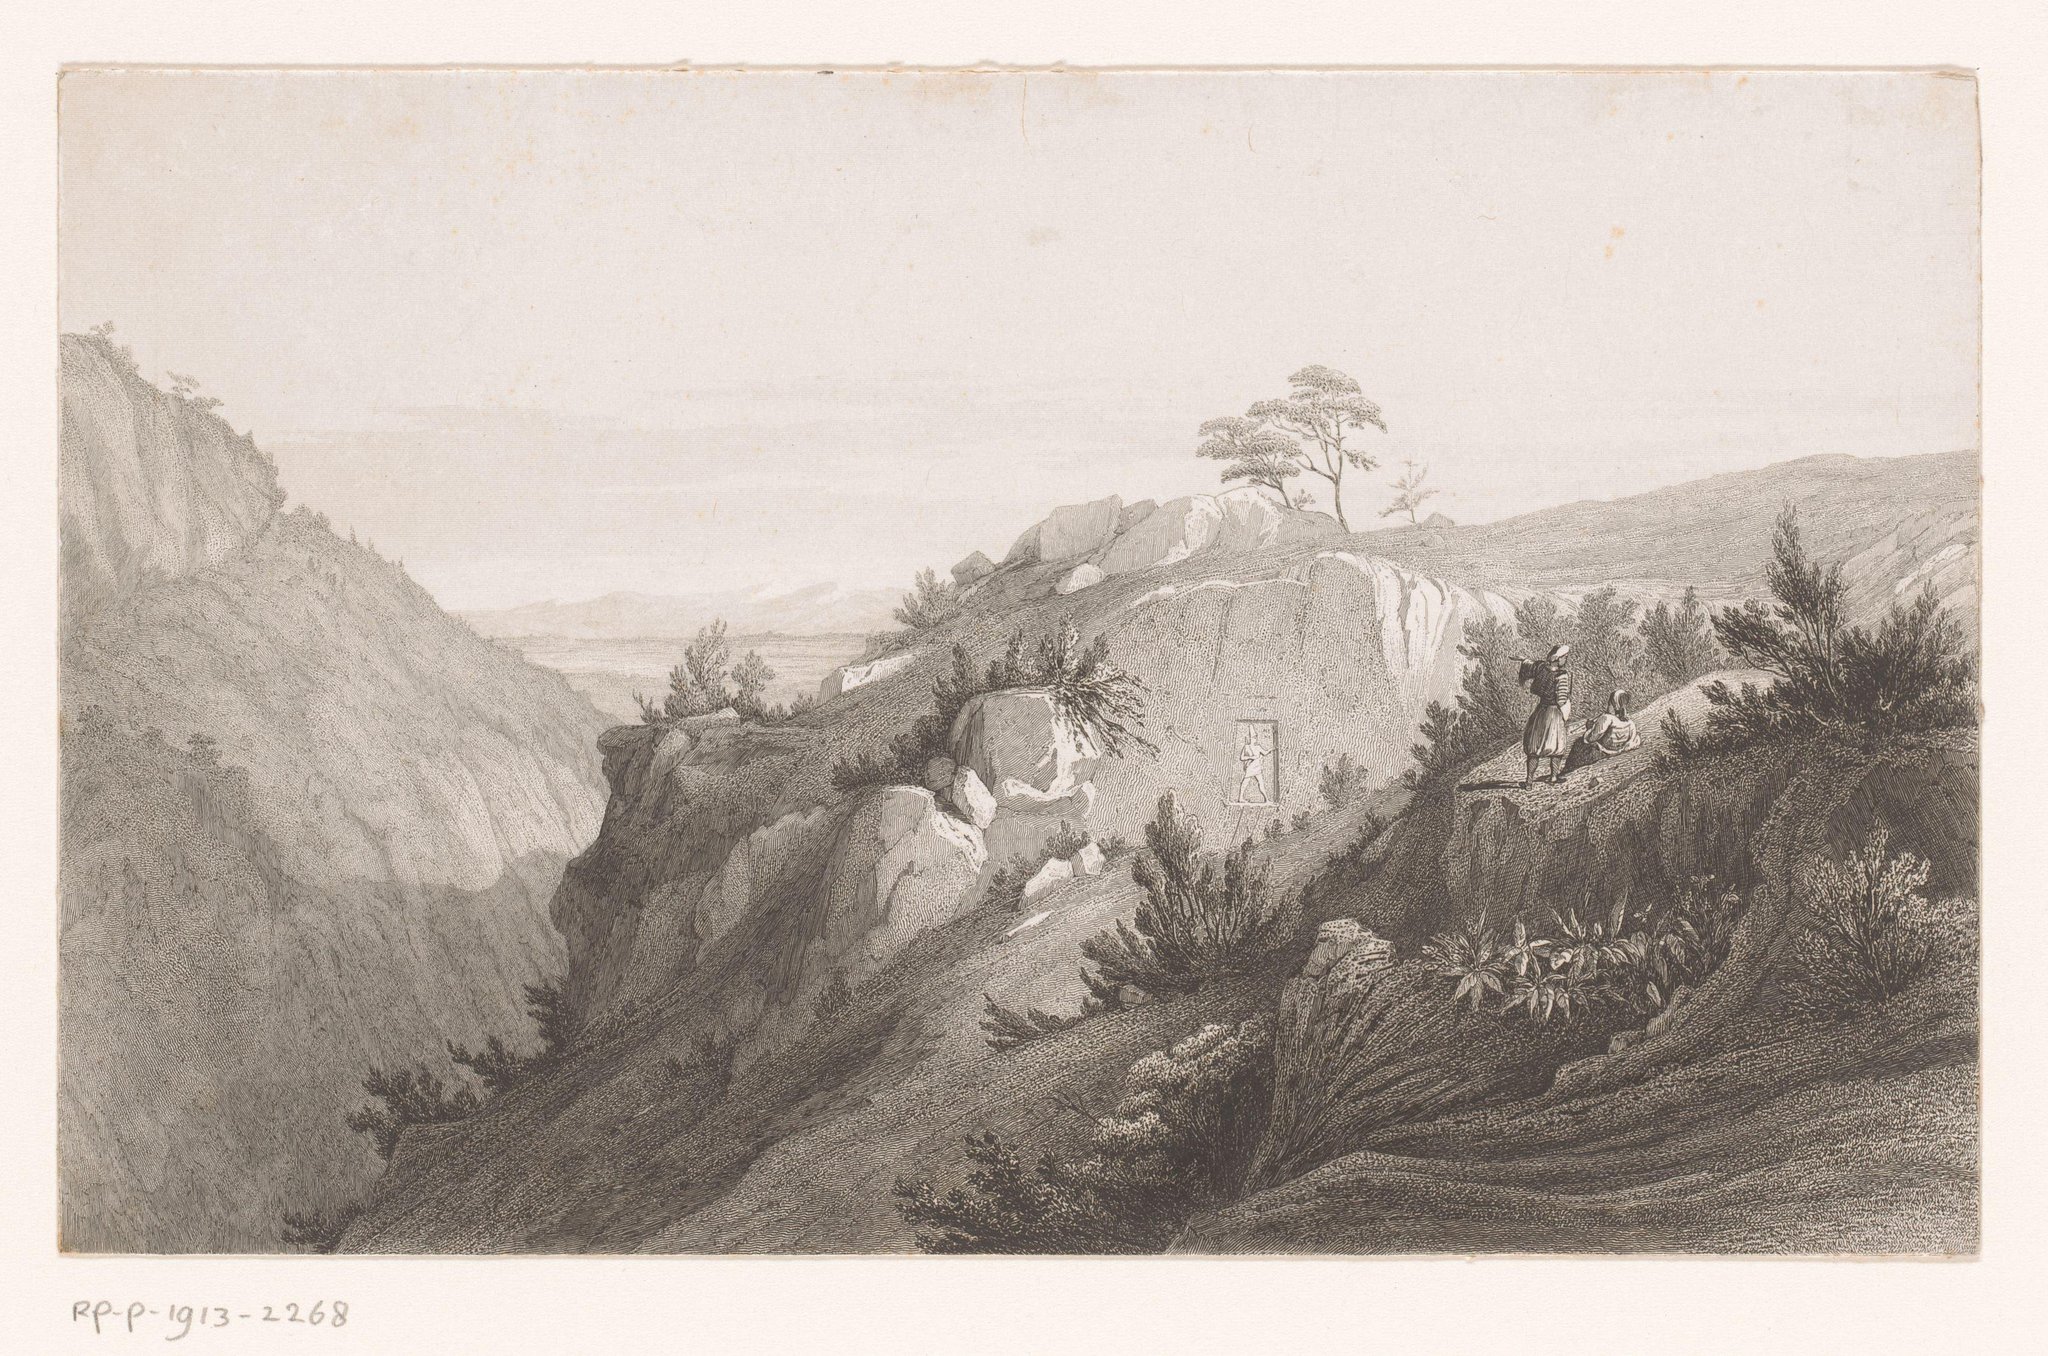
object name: print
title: Berglandschap met een in de rotsen en gebeitelde figuur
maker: auguste numans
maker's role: print maker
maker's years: 1823-1883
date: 1833-1880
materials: paper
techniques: etching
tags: (high) hill (+ landscape with figures, staffage), sculpture (+ relief ~ sculpture)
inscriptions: collector's mark: Lugt 2228